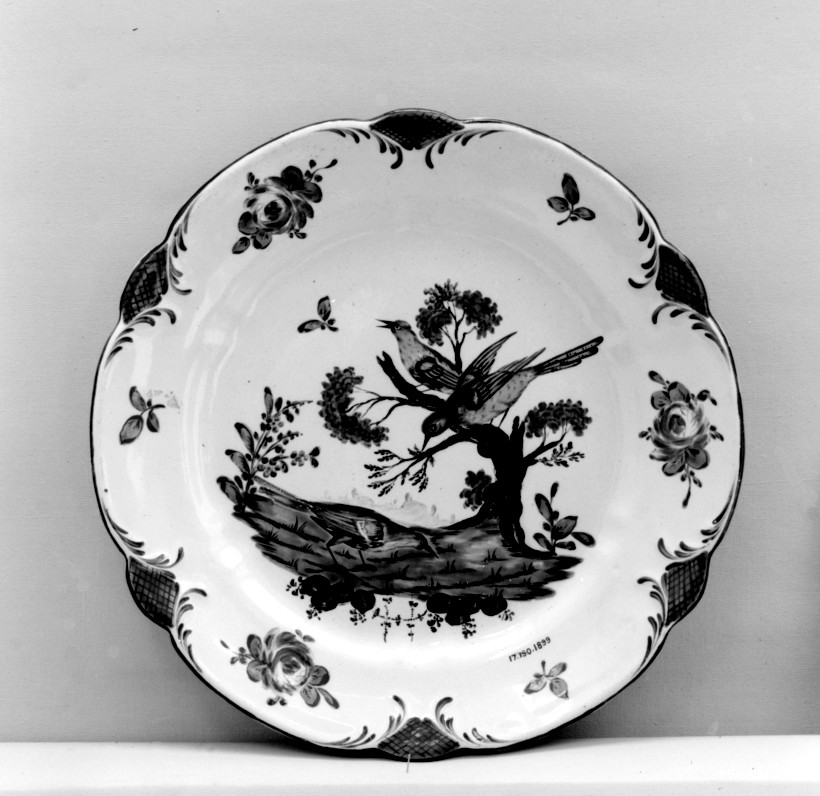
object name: plate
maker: levavasseur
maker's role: manufactory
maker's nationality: french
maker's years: 1715-1825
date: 1788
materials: faience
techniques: glazing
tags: birds,flowers,trees